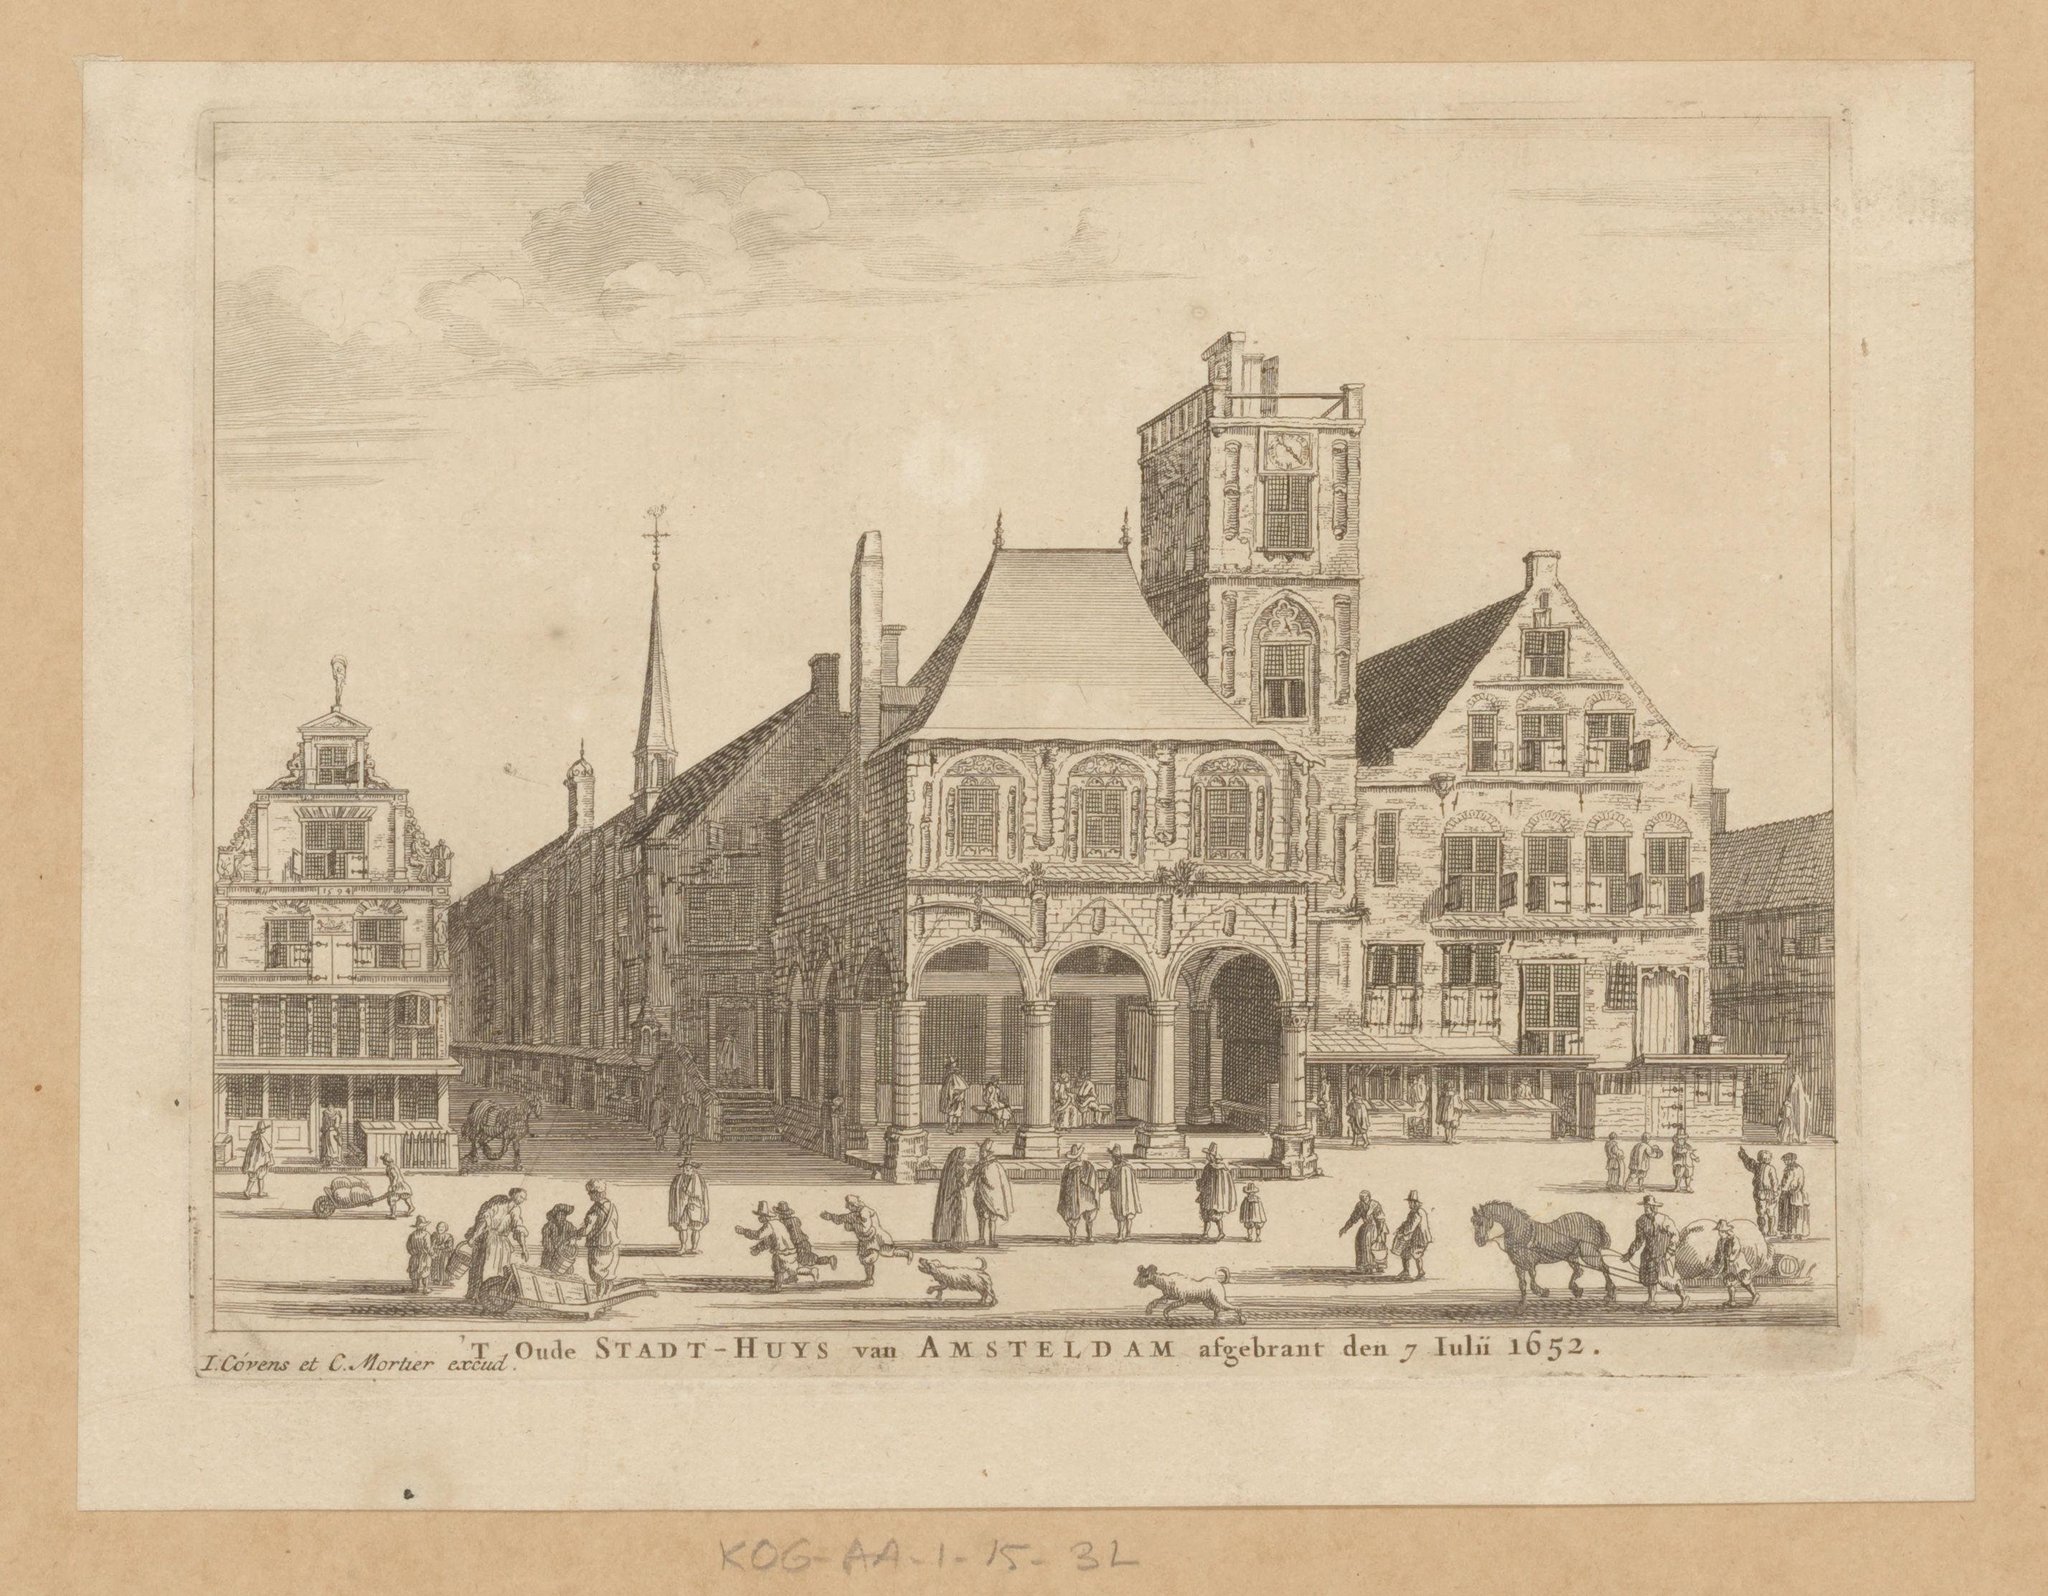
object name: print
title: Gezicht op het oude stadhuis van Amsterdam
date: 1720-1777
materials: paper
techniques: etching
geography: amsterdam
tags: square, place, circus, etc., city-view in general; 'veduta', townhall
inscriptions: collector's mark: ‘15,3 J-M’ Lugt 1641b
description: Onderwerpsrubriek binnen de Atlas Amsterdam: Oude Stadhuis, Oude Stadhuis op den Dam: c. zonder torenspits.